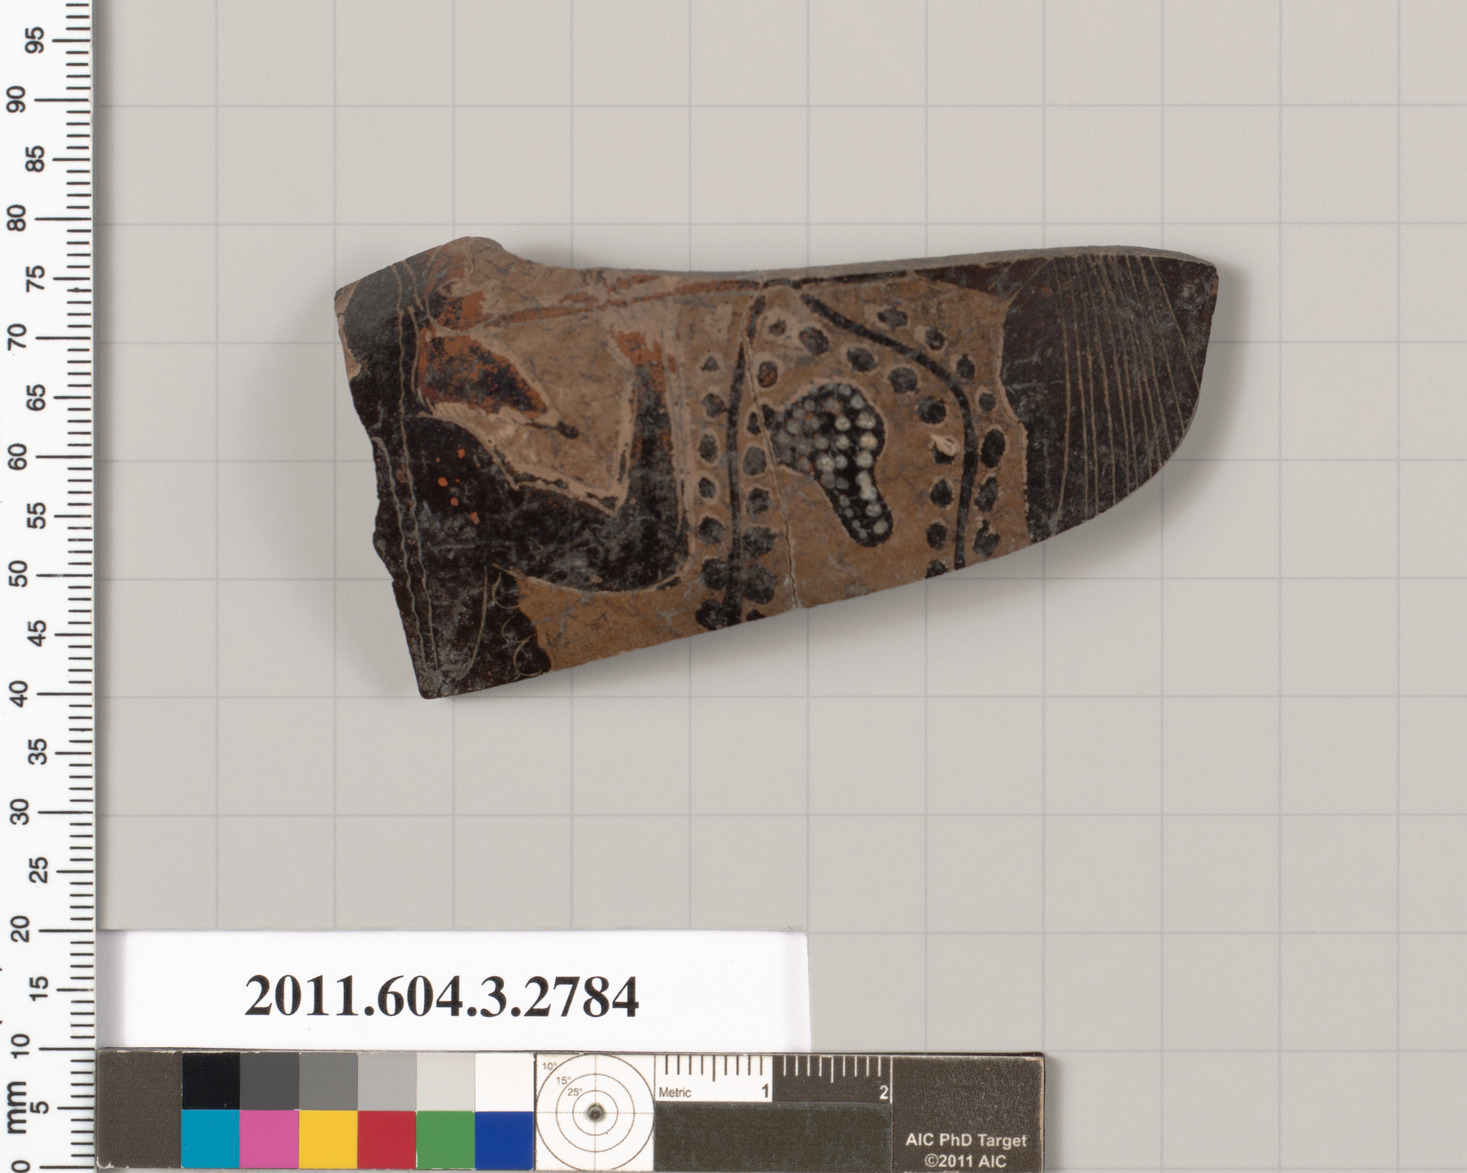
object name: oinochoe fragment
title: Terracotta fragment of an oinochoe (jug)?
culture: greek, attic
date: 530-520 BCE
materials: terracotta